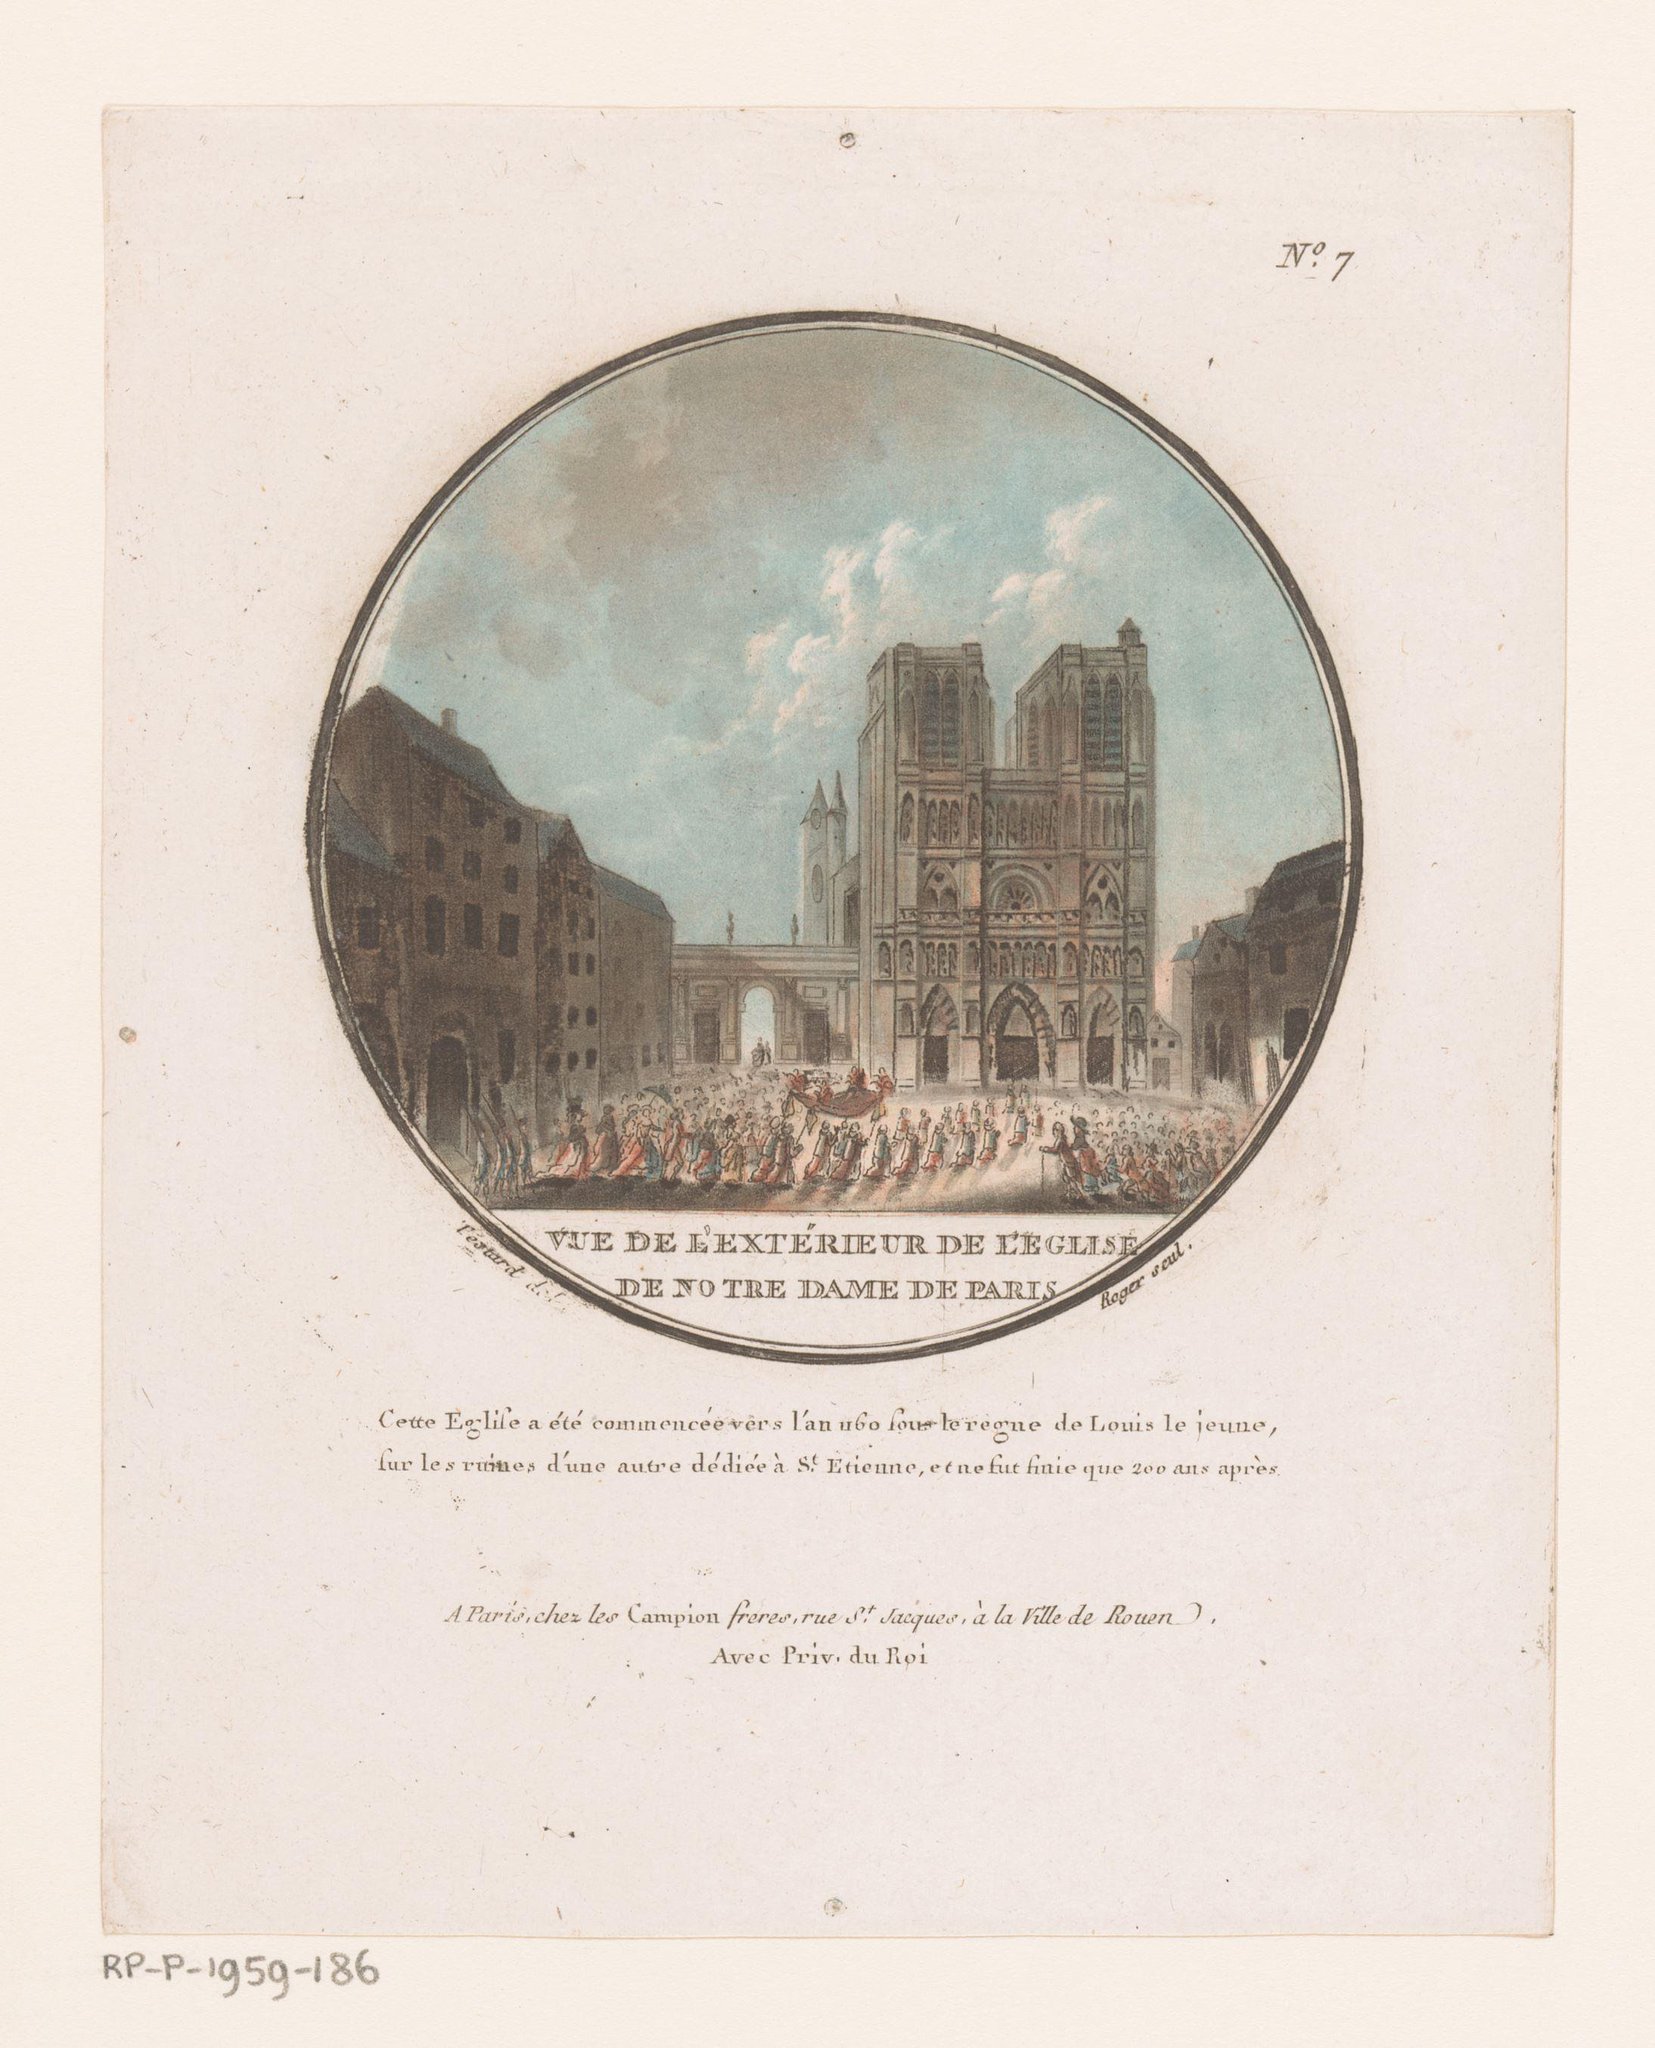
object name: print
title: Gezicht op de Notre-Dame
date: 1789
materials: paper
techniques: aquatint, etching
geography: france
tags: city-view in general; 'veduta', church (exterior)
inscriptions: collector's mark: Lugt 2228, collector's mark: Lugt 2760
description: Prent maakt deel uit van een serie van 110 cirkelvormige aquatinten door Le Campion, Guyot, Roger, Guillot, Belley en Mlle Guyot naar F.M. Testard en Sergent.